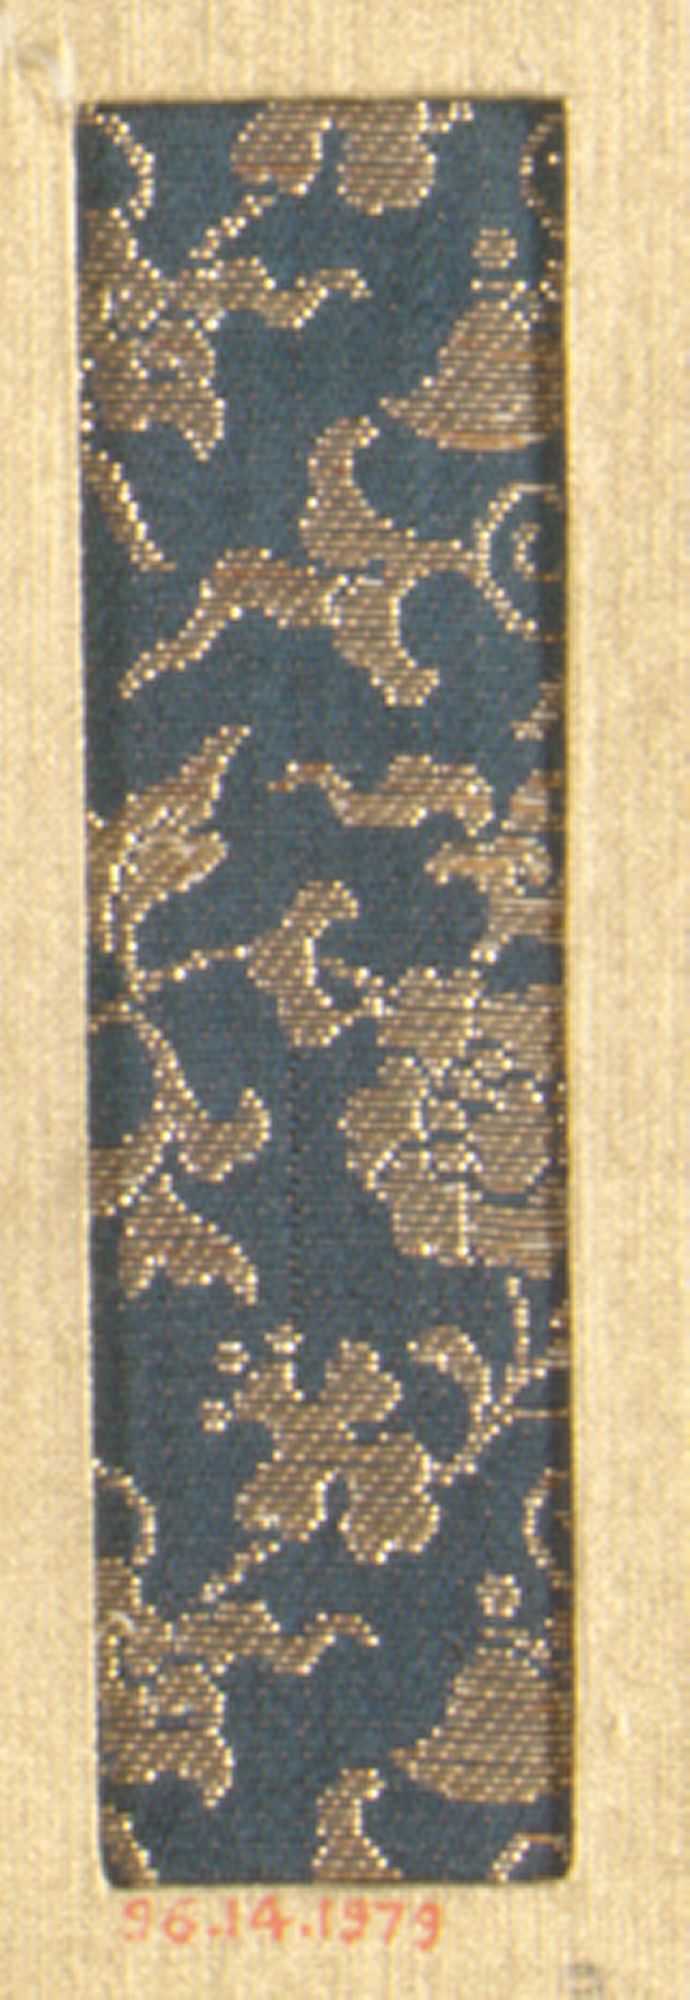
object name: piece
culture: japanese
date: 1701-1900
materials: silk